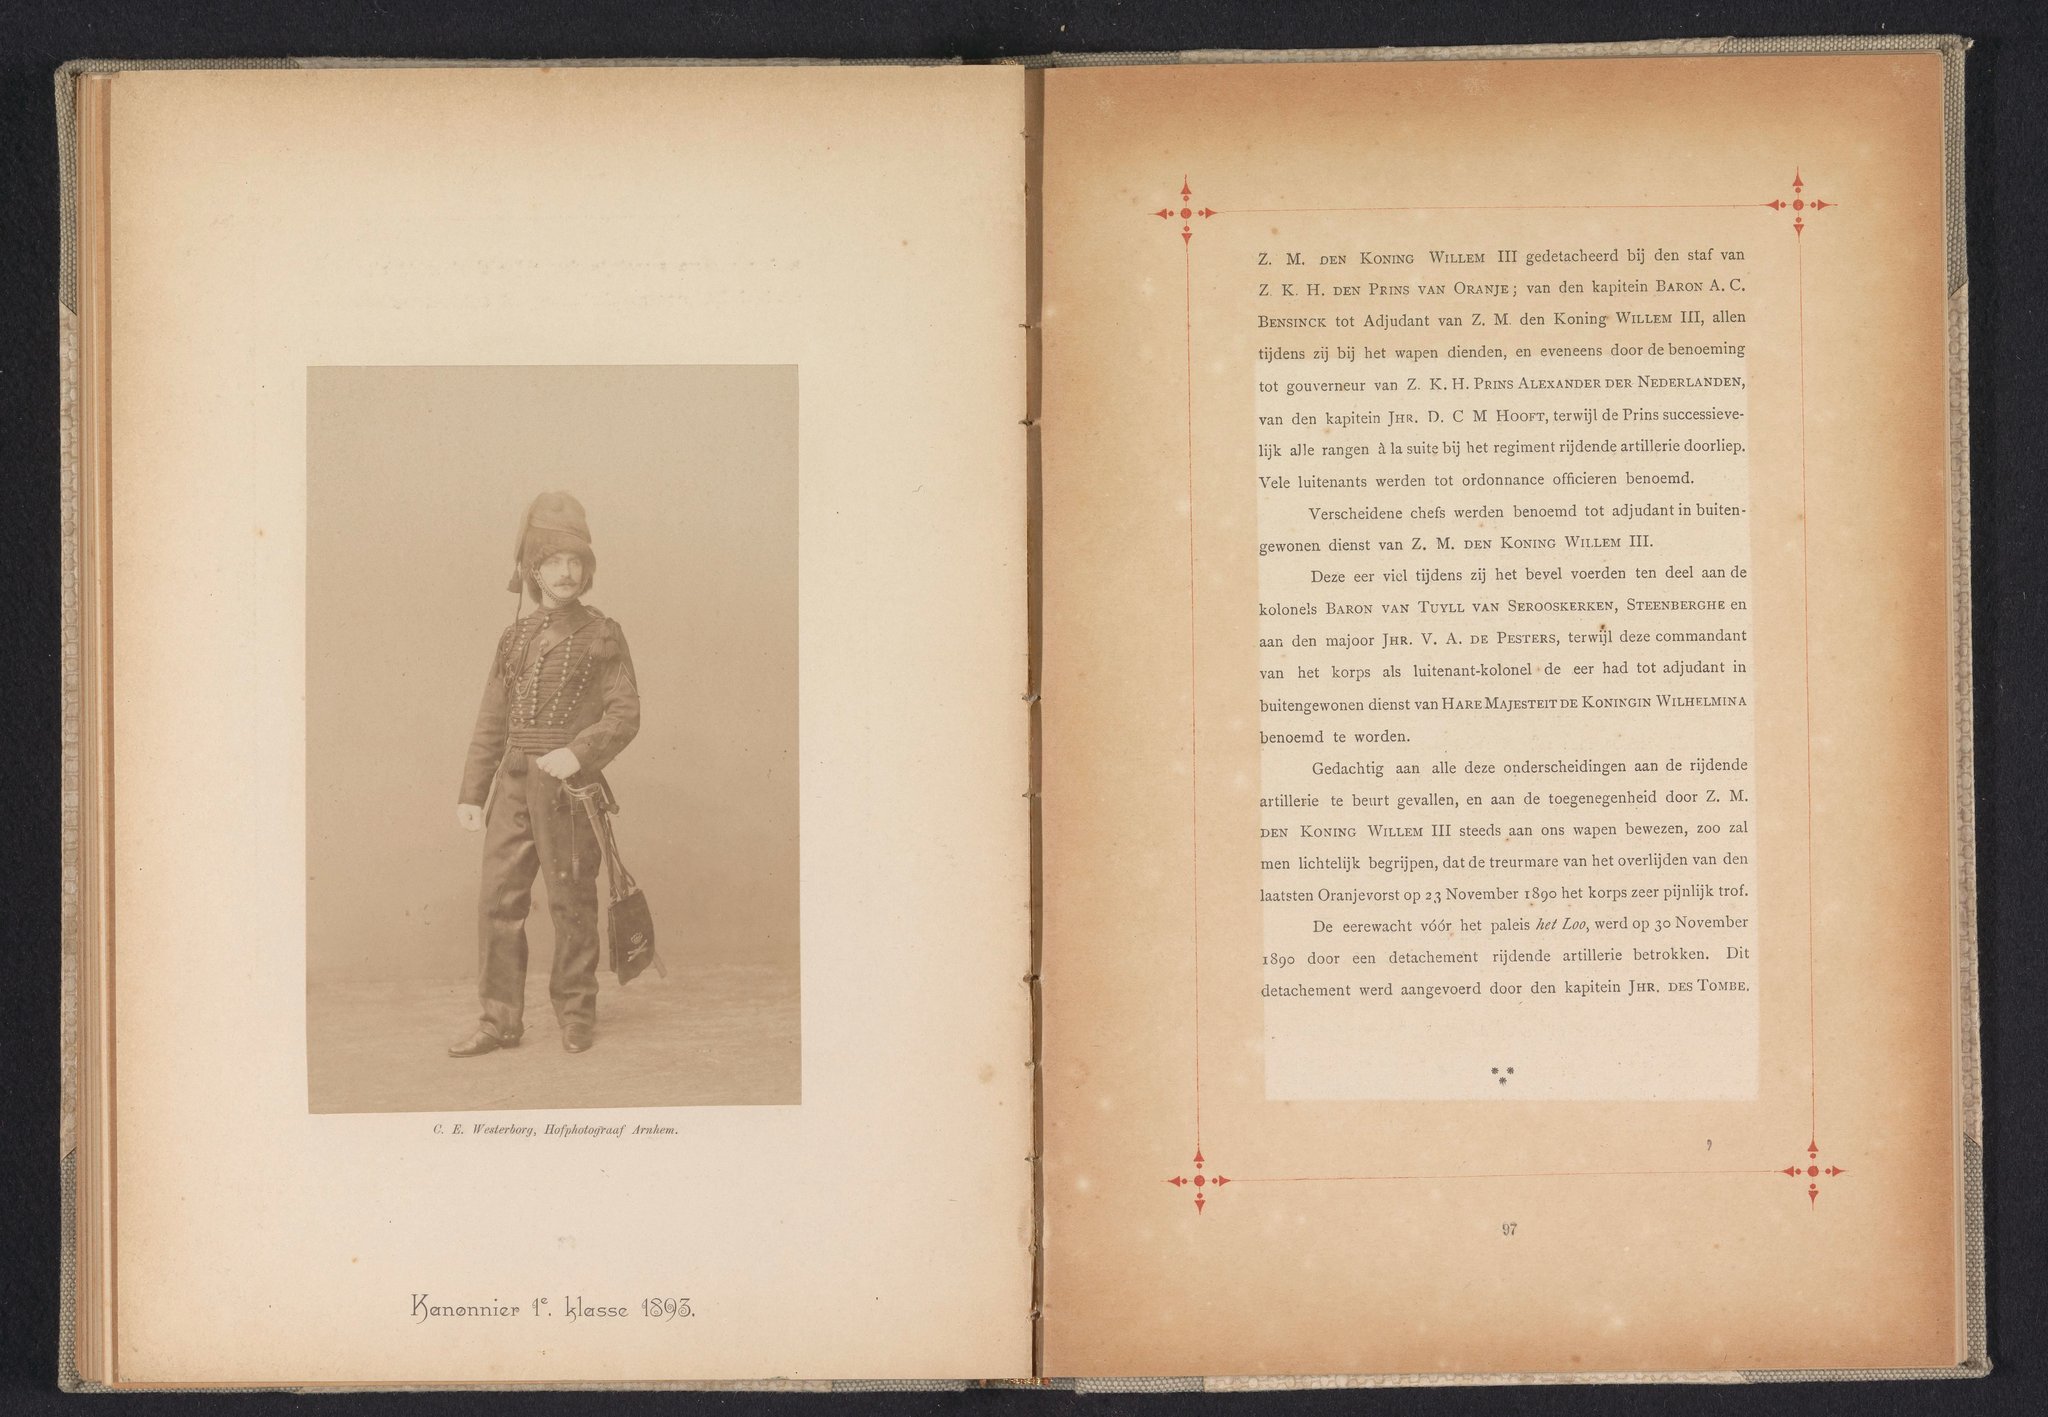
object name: photograph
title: Kanonnier 1e. klasse 1893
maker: carel eduard westerborg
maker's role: fotograaf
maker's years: 1842-1916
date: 1893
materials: photographic support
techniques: albumen print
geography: arnhem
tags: (military) uniforms